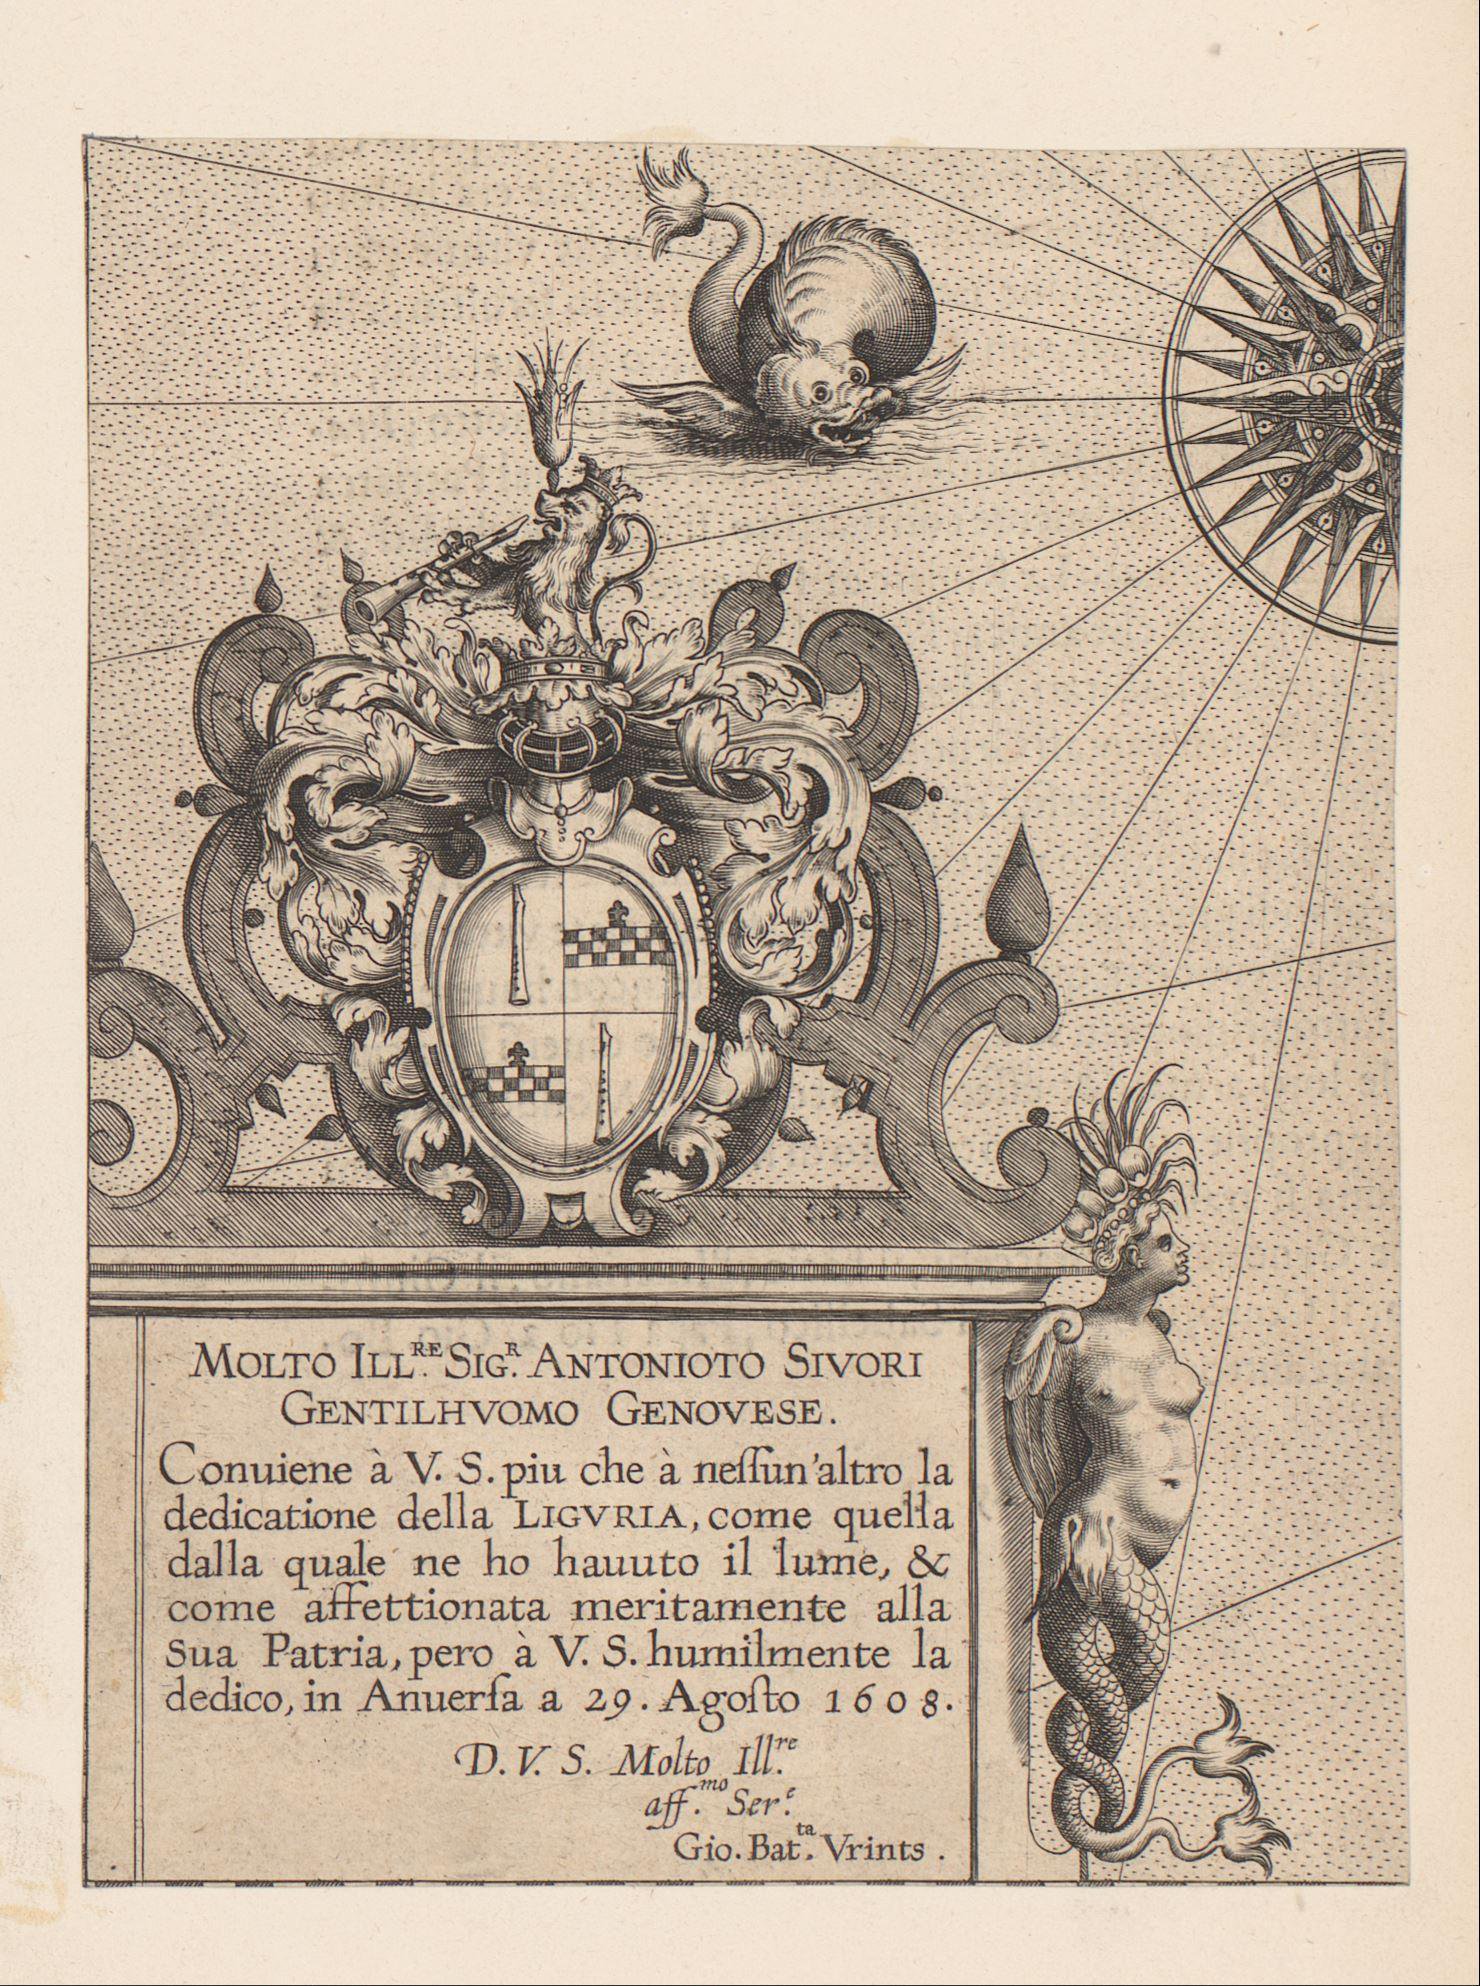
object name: ornament print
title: Theatrum Orbis Terrarum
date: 1608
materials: paper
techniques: engraving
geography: antwerp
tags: antonio sivori, coat of arms (as symbol of the state, etc.), merman - aa - mermaid, siren, ornament ~ cartouche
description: Hoekcartouche met rechts een fabelachtig vrouwelijk wezen met vissenstaart. Bovenop het wapenschild van Antonio Savori. De cartouche is een fragment van een kaart van Ligurië. De prent maakt deel uit van een album.